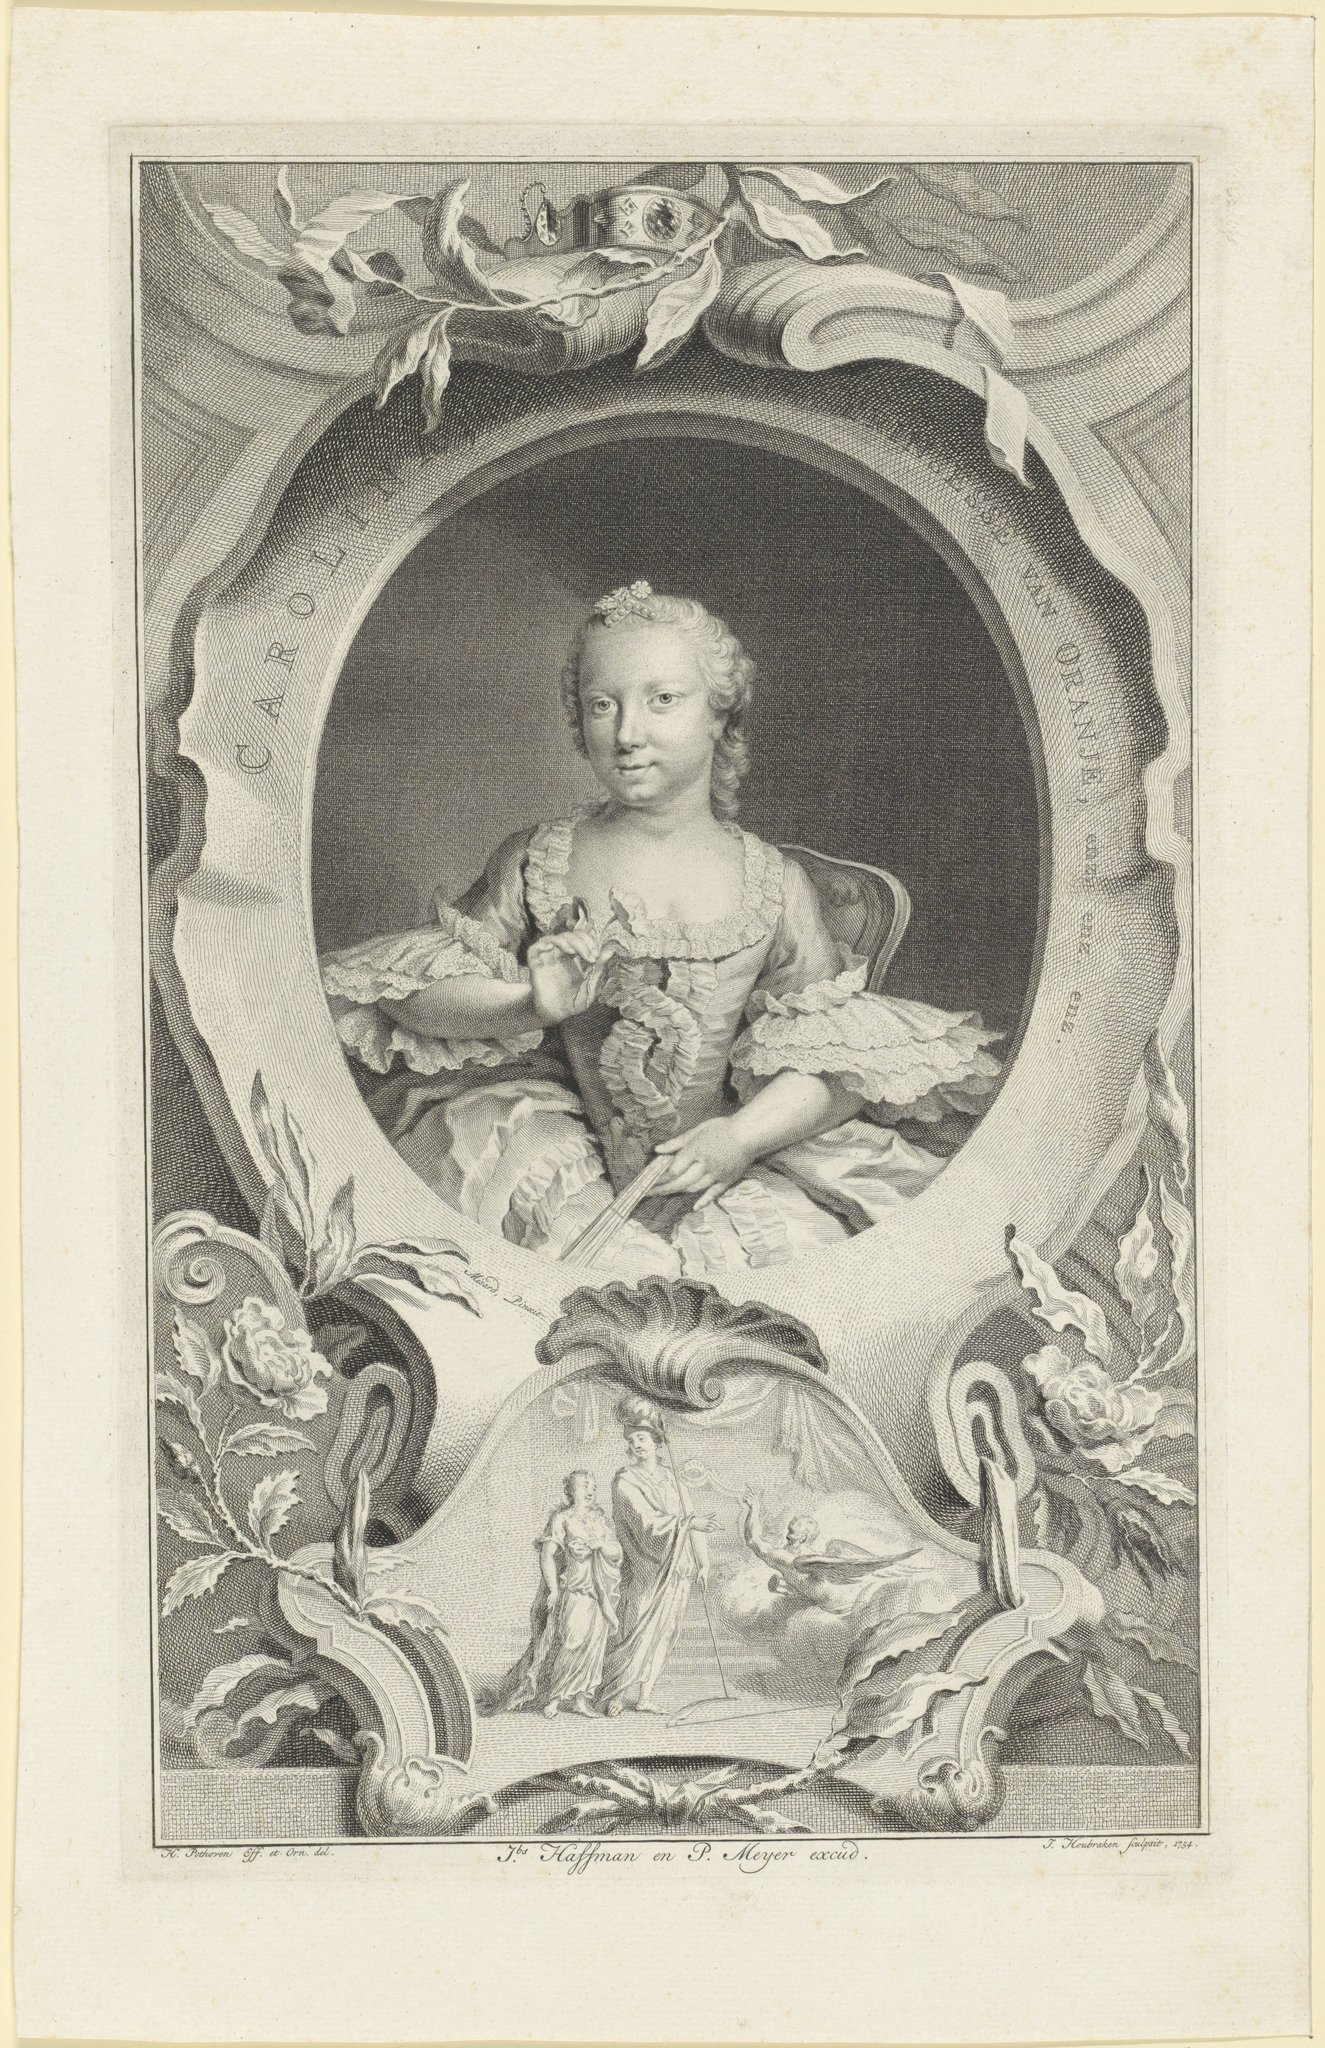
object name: print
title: Portret van Carolina, prinses van Oranje-Nassau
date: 1754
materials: paper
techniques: engraving, etching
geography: amsterdam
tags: carolina (prinses van oranje-nassau), (story of) minerva (pallas, athena)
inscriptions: collector's mark: Lugt 963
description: Portret van Carolina in een ovaal met randschrift. Rondom ligt een aantal allegorische objecten. Op het reliëf een allegorische voorstelling waarin Minerva de jonge Carolina wijst op Vader Tijd.